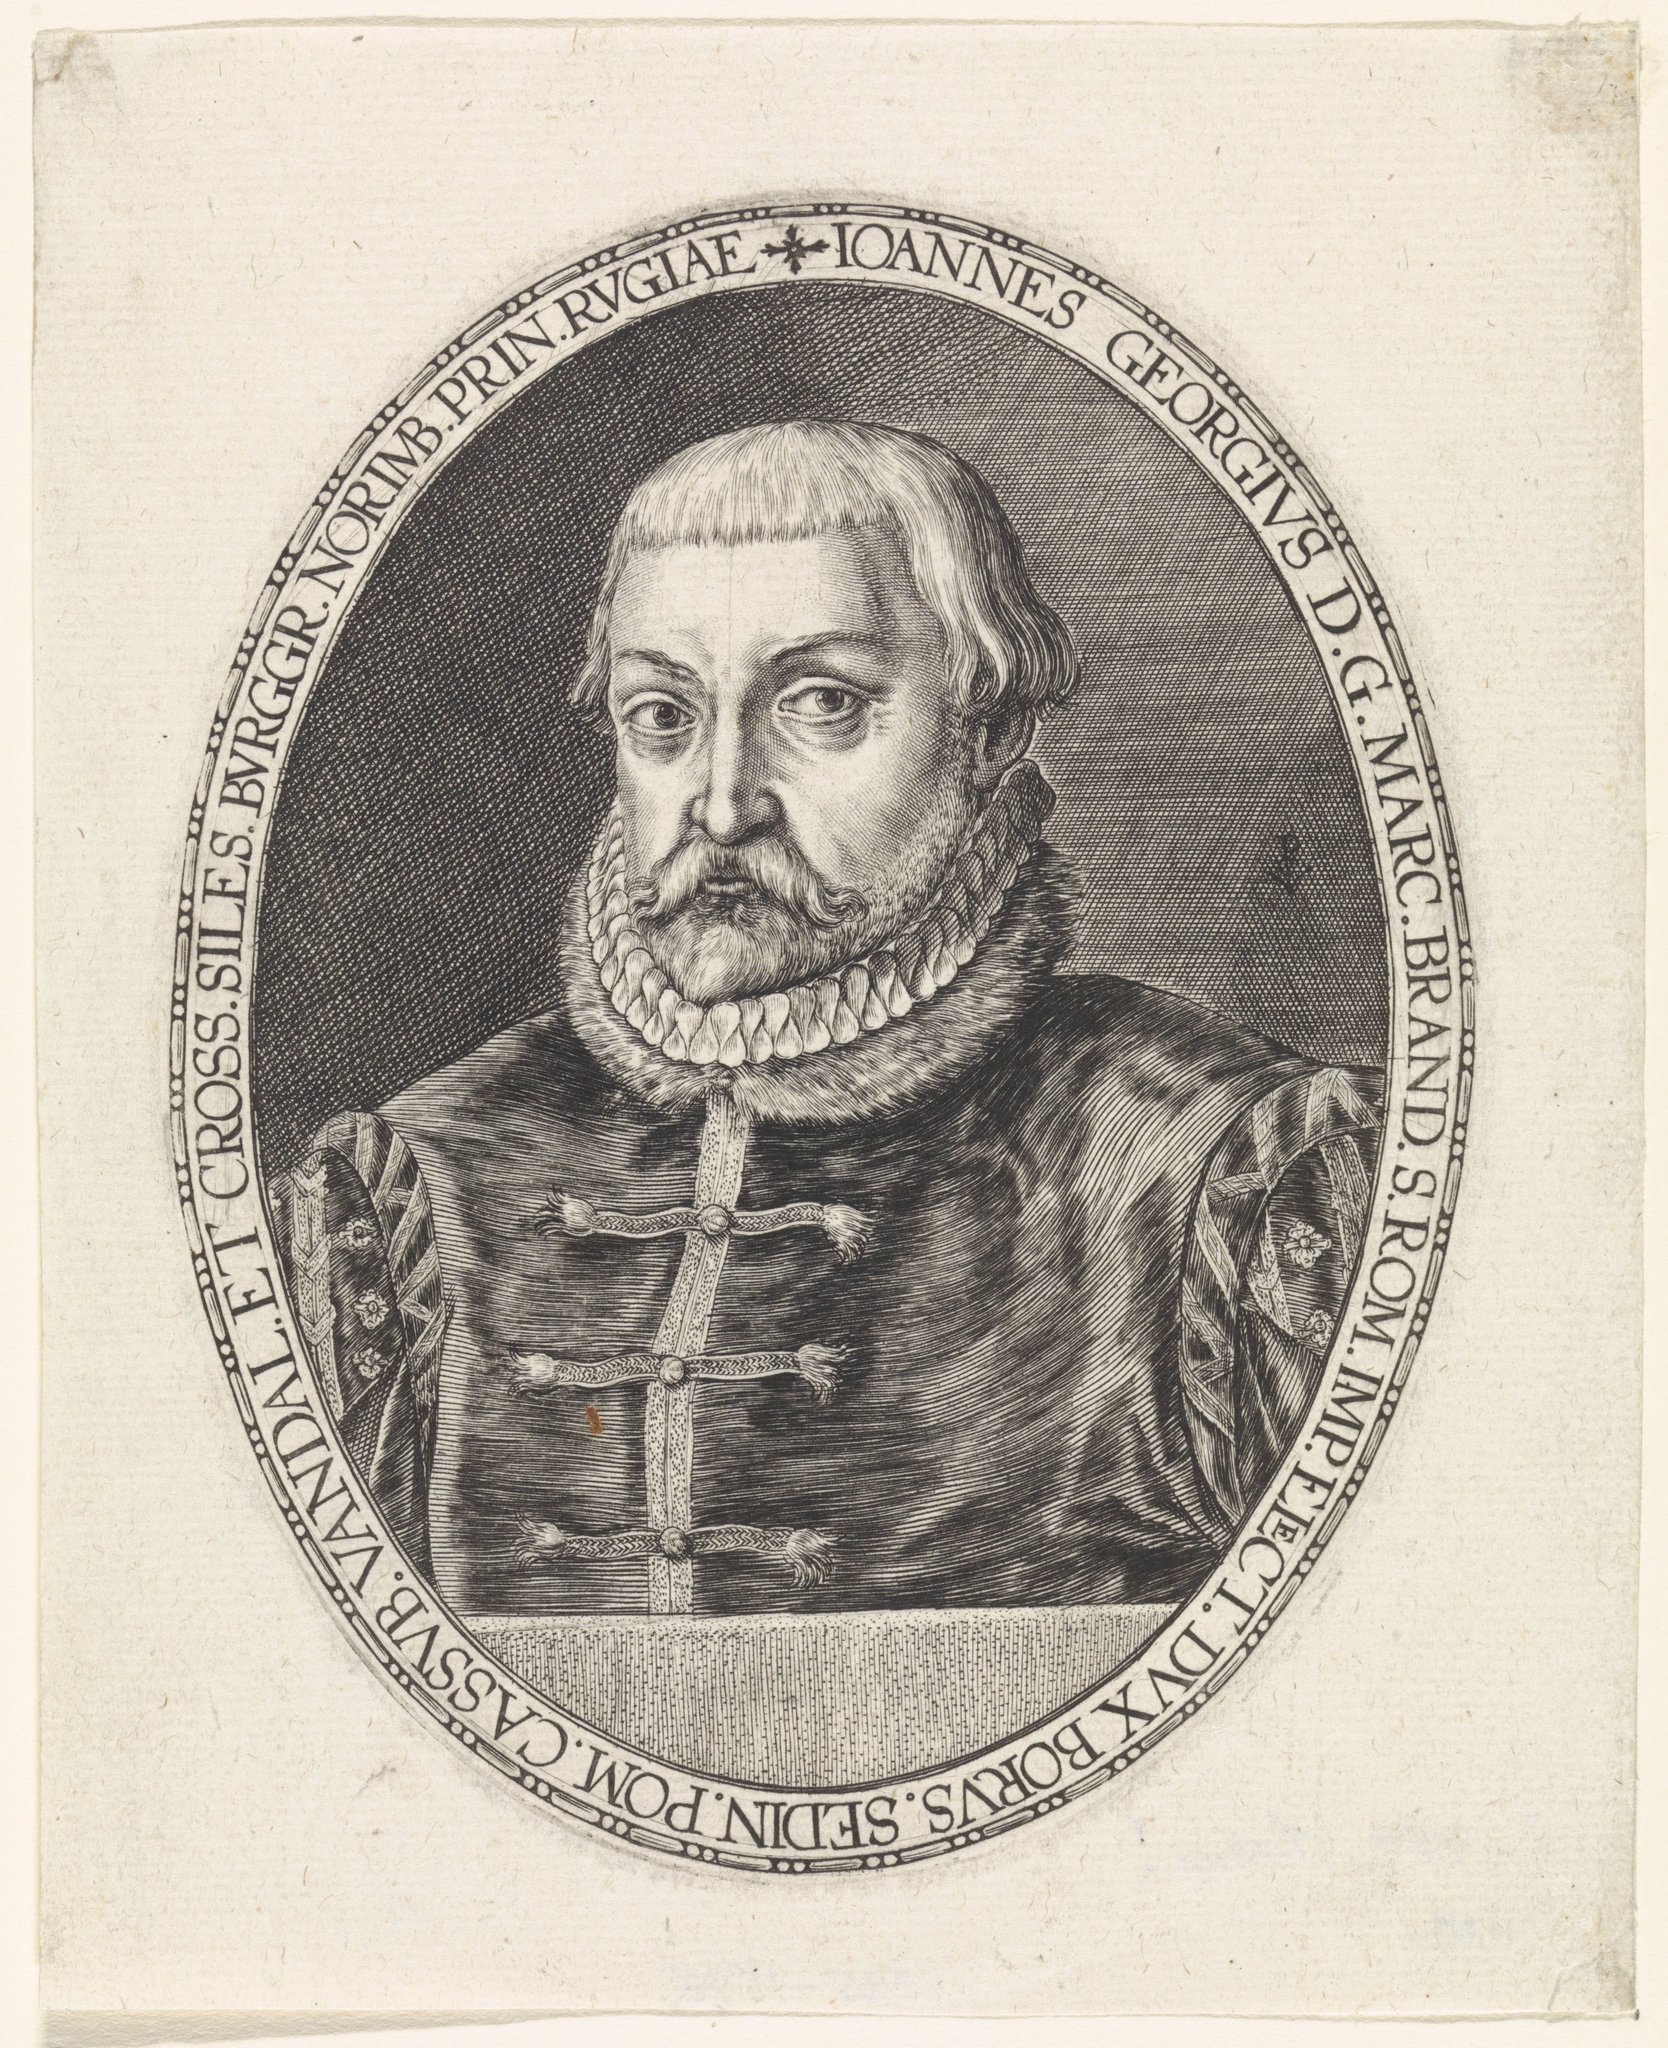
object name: print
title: Portret van Johan George van Brandenburg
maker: crispijn van de passe (i)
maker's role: draughtsman, print maker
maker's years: 1564-1637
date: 1574-1637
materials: paper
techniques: engraving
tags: cologne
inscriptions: collector's mark: Lugt 2228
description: Portret van Johan George van Brandenburg, bijgenaamd Oeconomicus, keurvorst van Brandenburg. In het randschrift van de omlijsting de naam en functie van de geportretteerde in het Latijn.